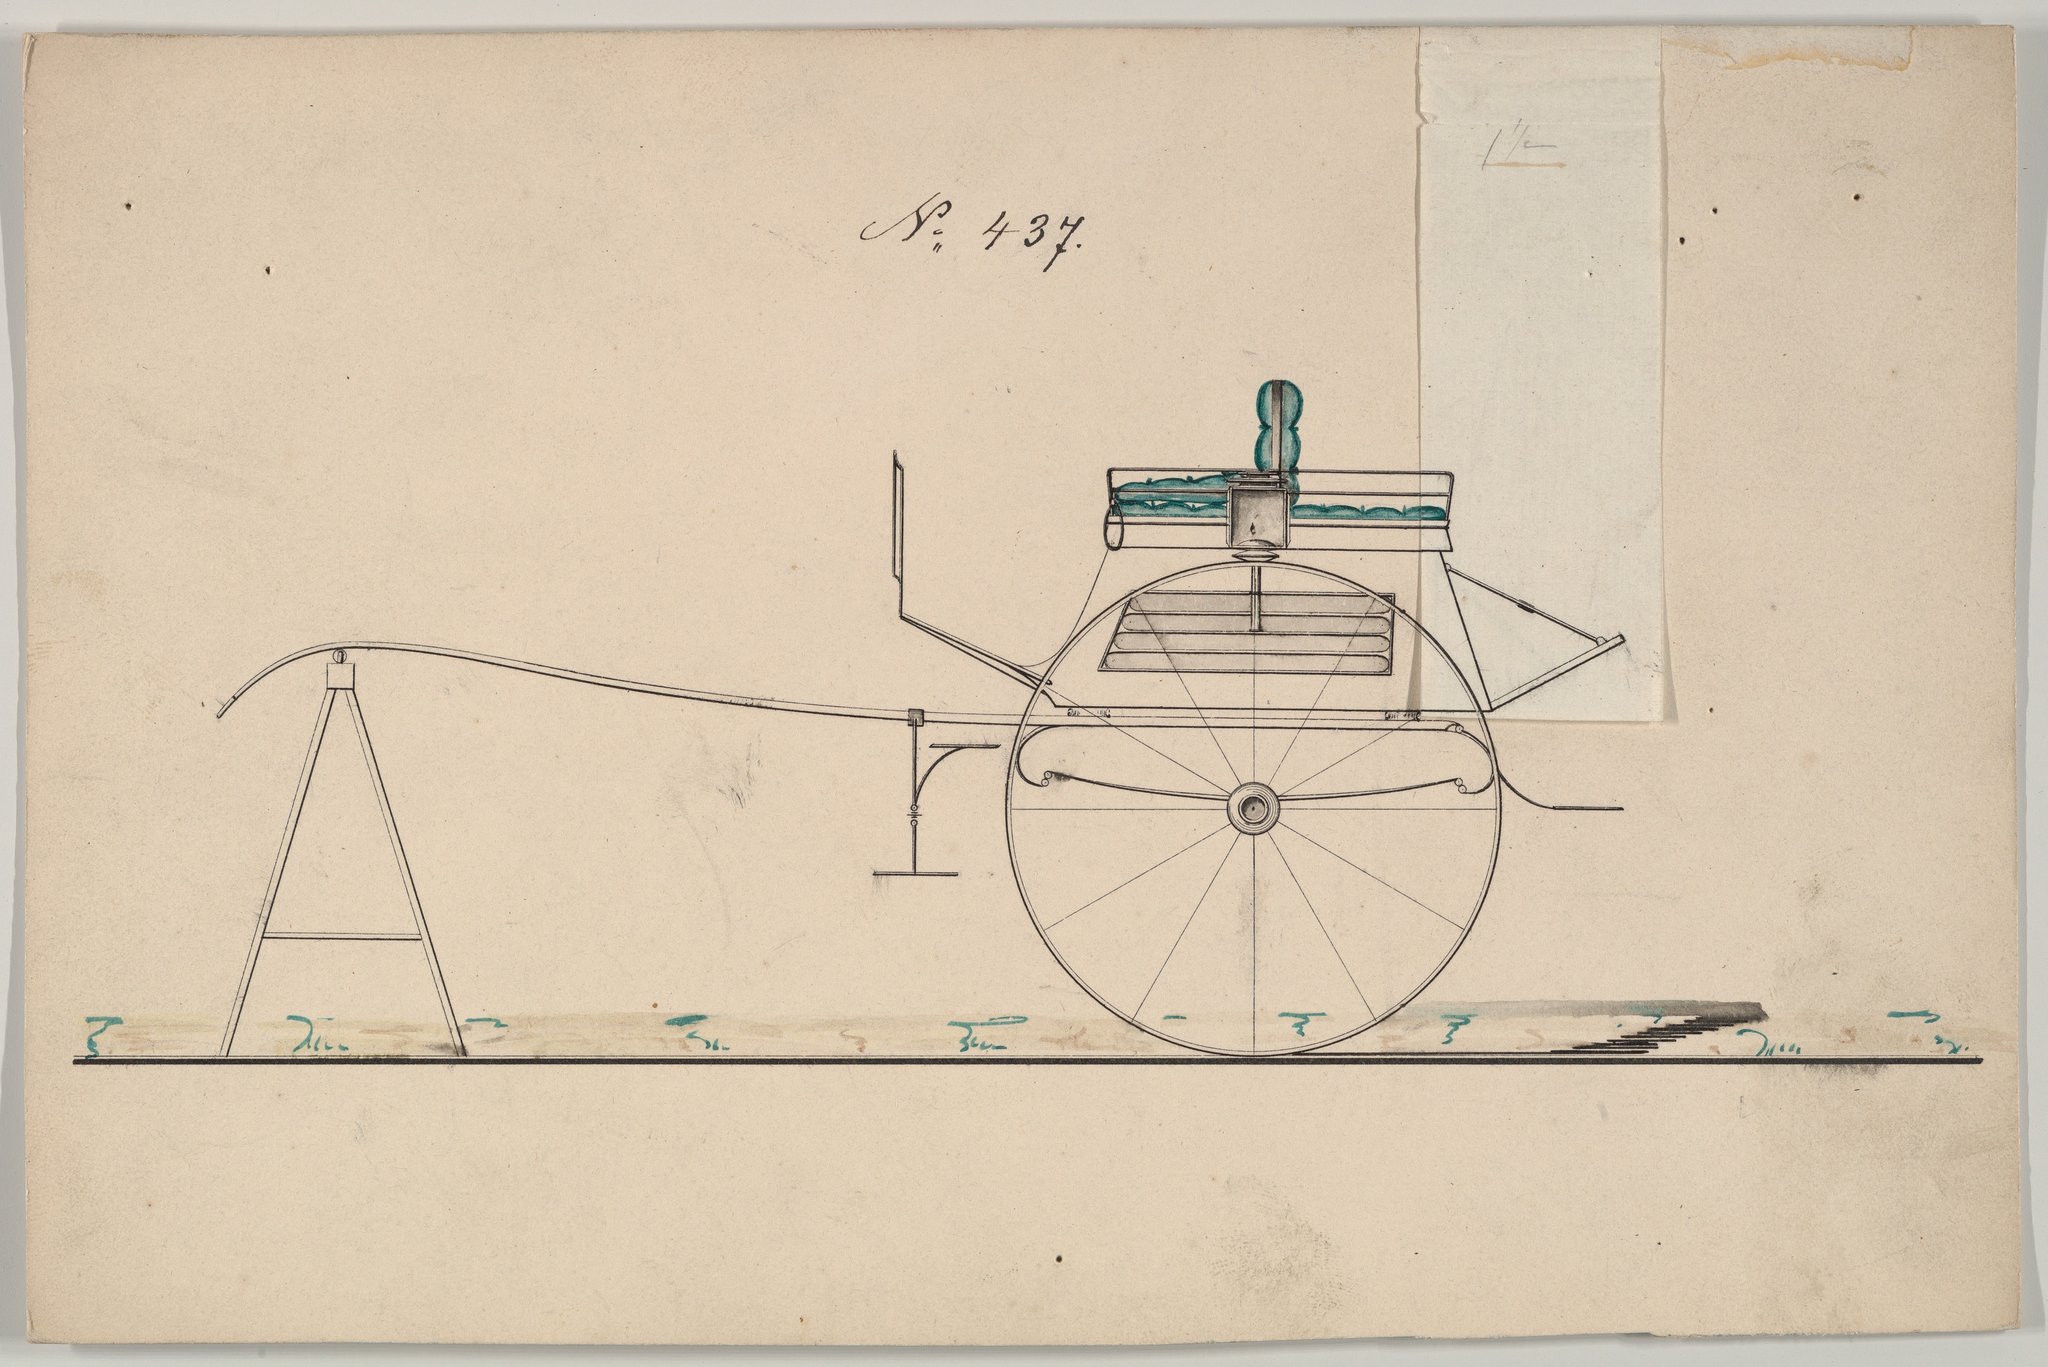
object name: drawing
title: Dog Cart #437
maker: brewster & co.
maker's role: manufacturer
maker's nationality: american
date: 1850-1870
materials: ink, watercolor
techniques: pen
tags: carriages